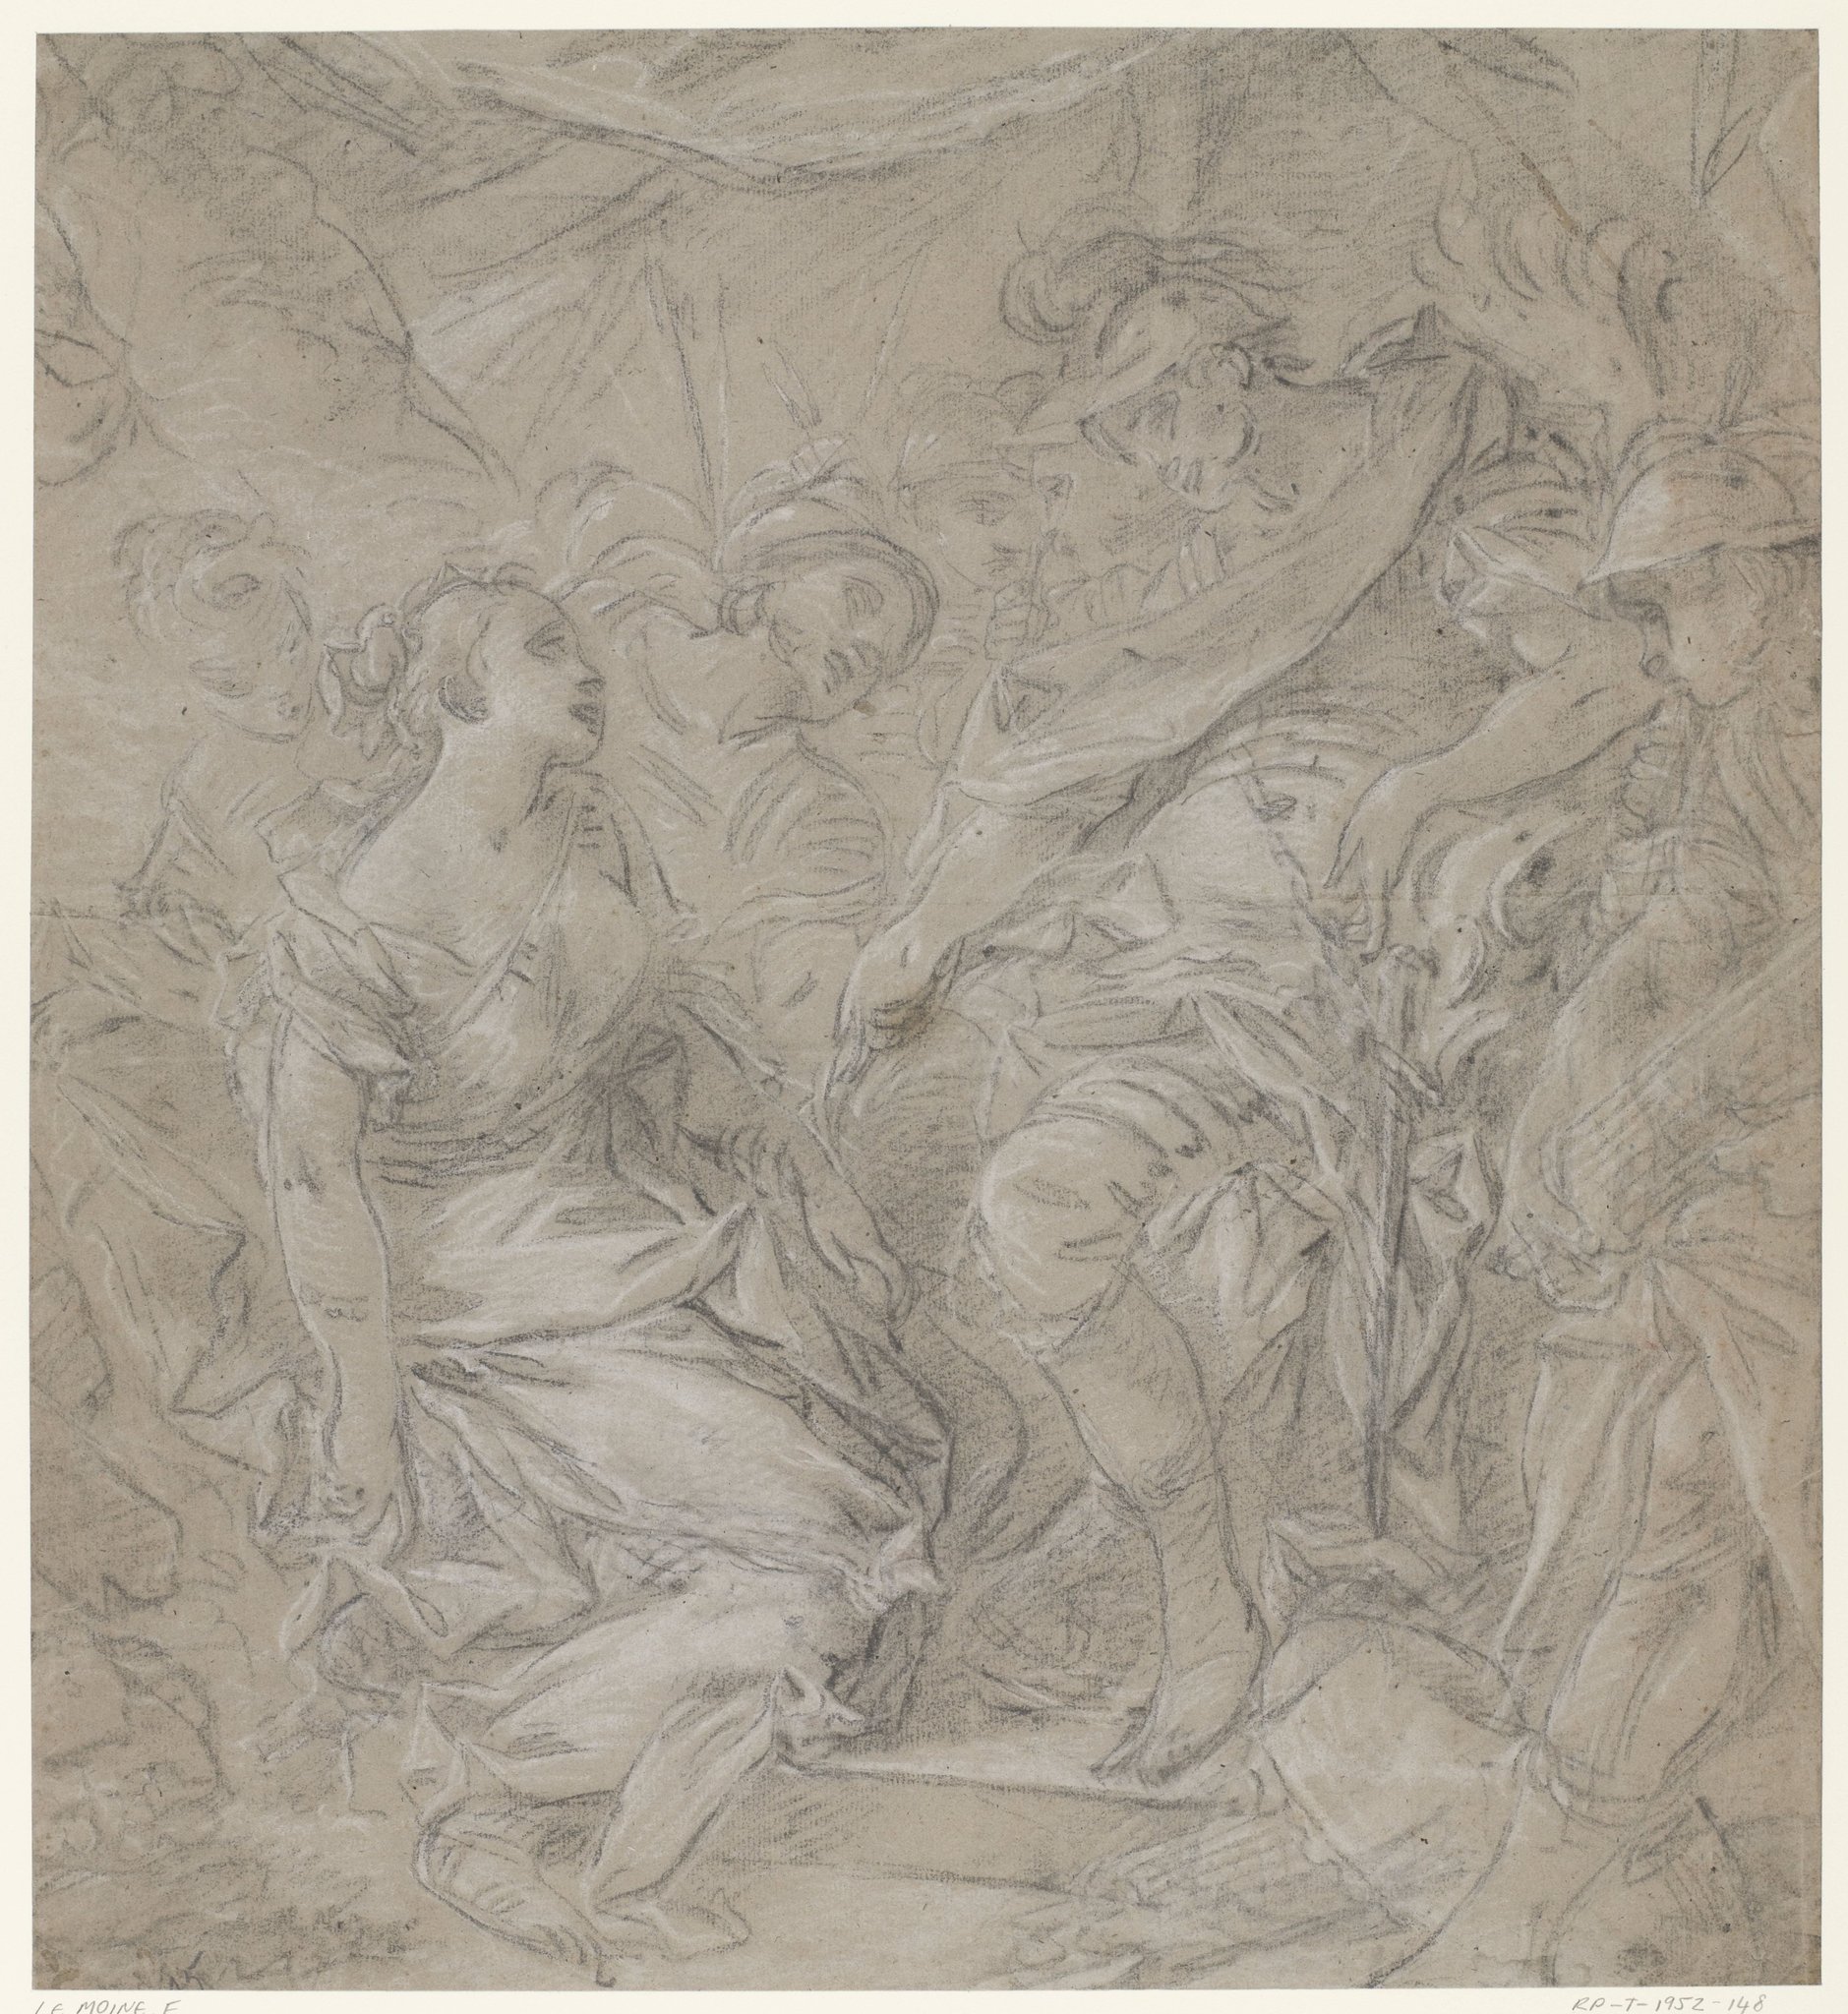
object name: drawing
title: Jonge vrouw knielend voor een veldheer in zijn tent (Scipio?)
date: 1698-1737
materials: chalk, paper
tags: the continence of scipio: he restores a captive woman to her bridegroom allucius, who kneels before him; the ransom offered by the bride's parents is given to allucius as a wedding-gift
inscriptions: collector's mark, verso, centre: Lugt 2228, collector's mark, verso, centre: Lugt 2760, annotation, verso, lower right, pencil: ‘Ecole française / La supplication’, stamp, verso, lower right, stamped in purple ink: ‘douane centrale / exportation / Paris’